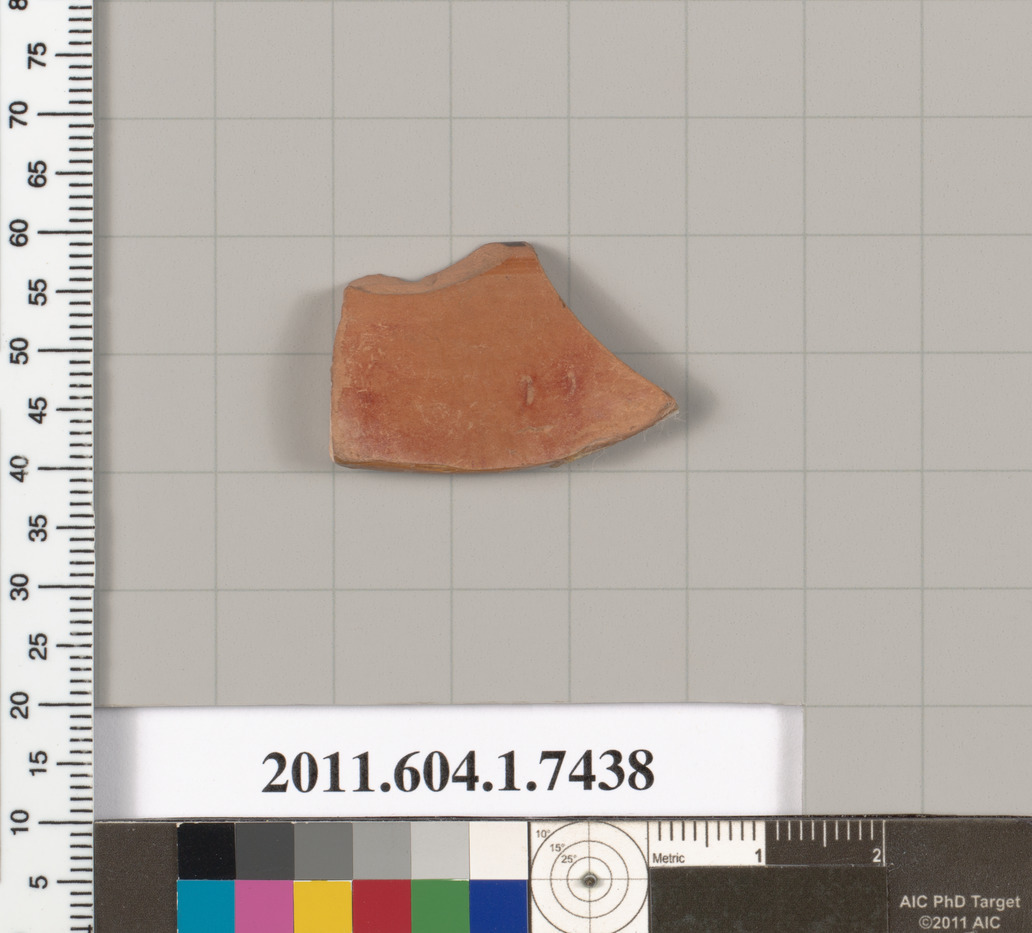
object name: kylix fragment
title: Terracotta fragment of a kylix (drinking cup)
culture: greek, attic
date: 490-470 BCE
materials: terracotta